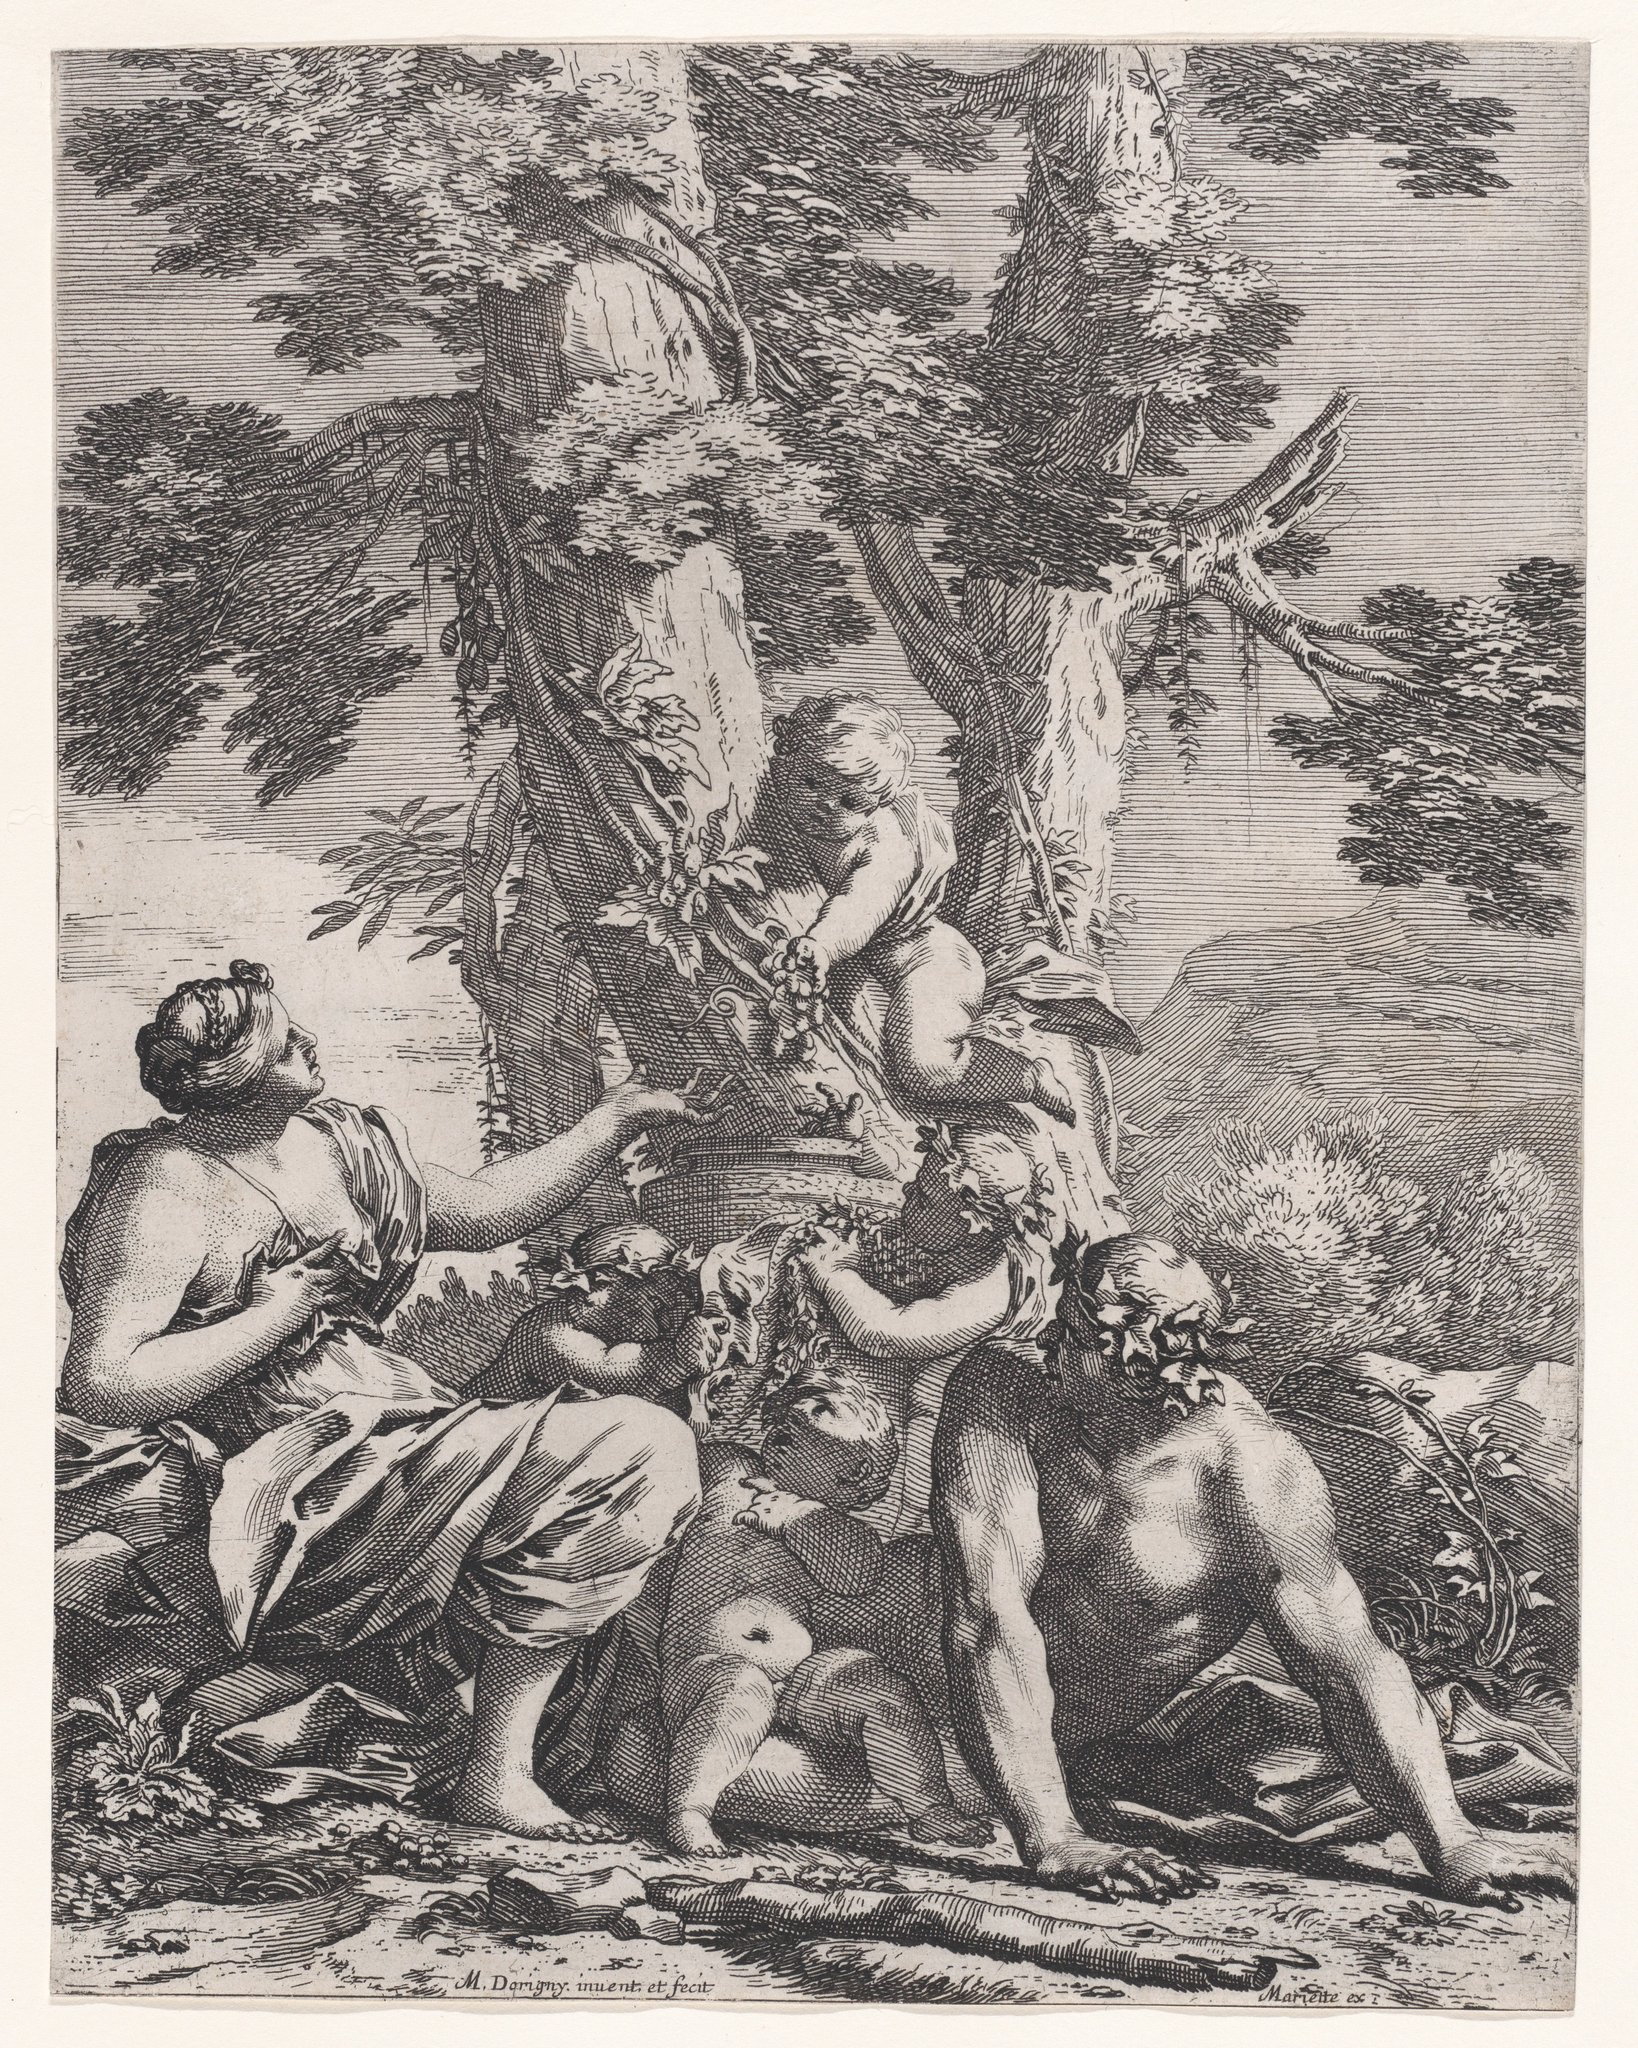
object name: print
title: Putti and bacchantes at the bottom of a tree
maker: michel dorigny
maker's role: artist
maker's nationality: french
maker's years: 1616-1665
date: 1636-1665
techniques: etching